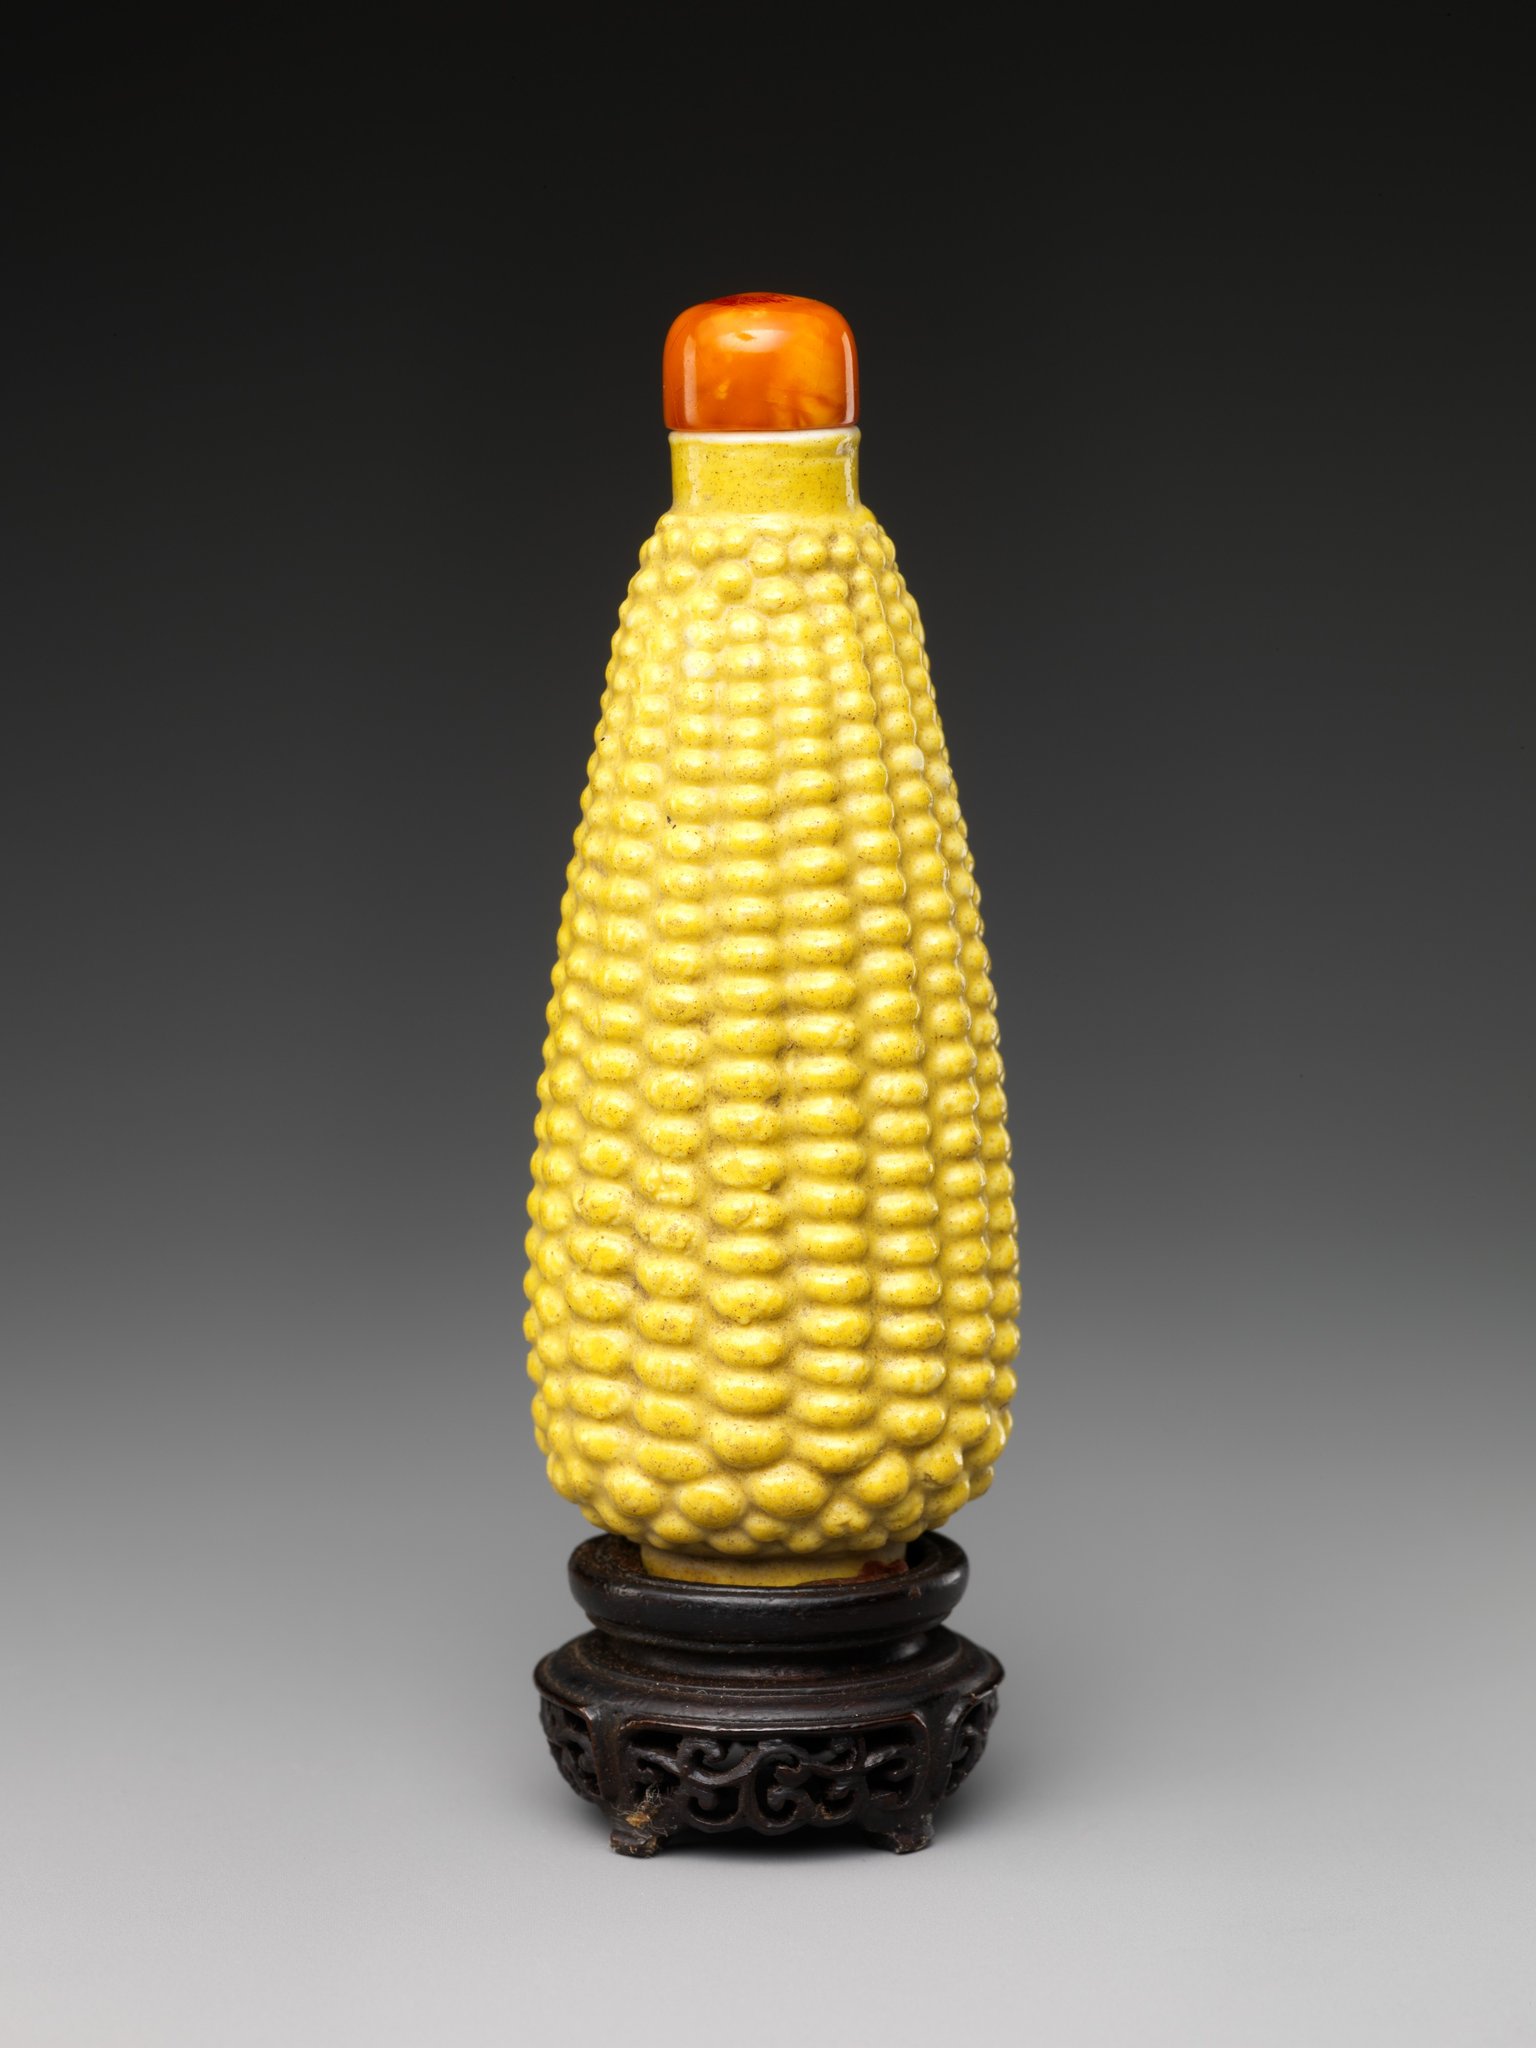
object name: snuff bottle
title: Snuff bottle in the shape of an ear of corn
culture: chinese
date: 1767-1900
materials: amber, glaze, porcelain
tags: corn